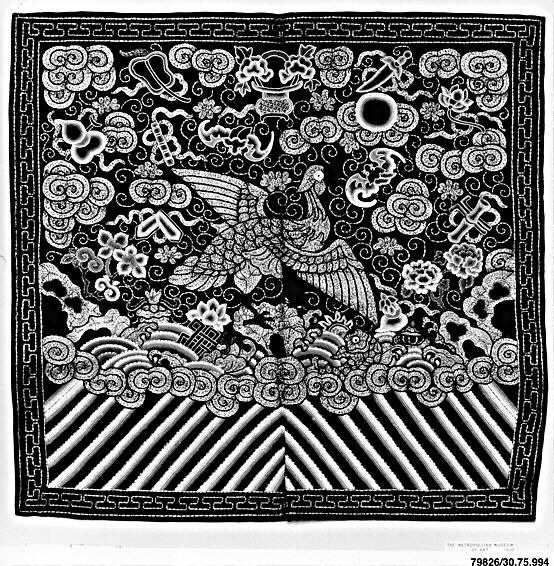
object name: rank badge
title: Rank Badge with Mandarin Duck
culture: chinese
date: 1767-1833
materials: metal thread, silk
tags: bats,ducks